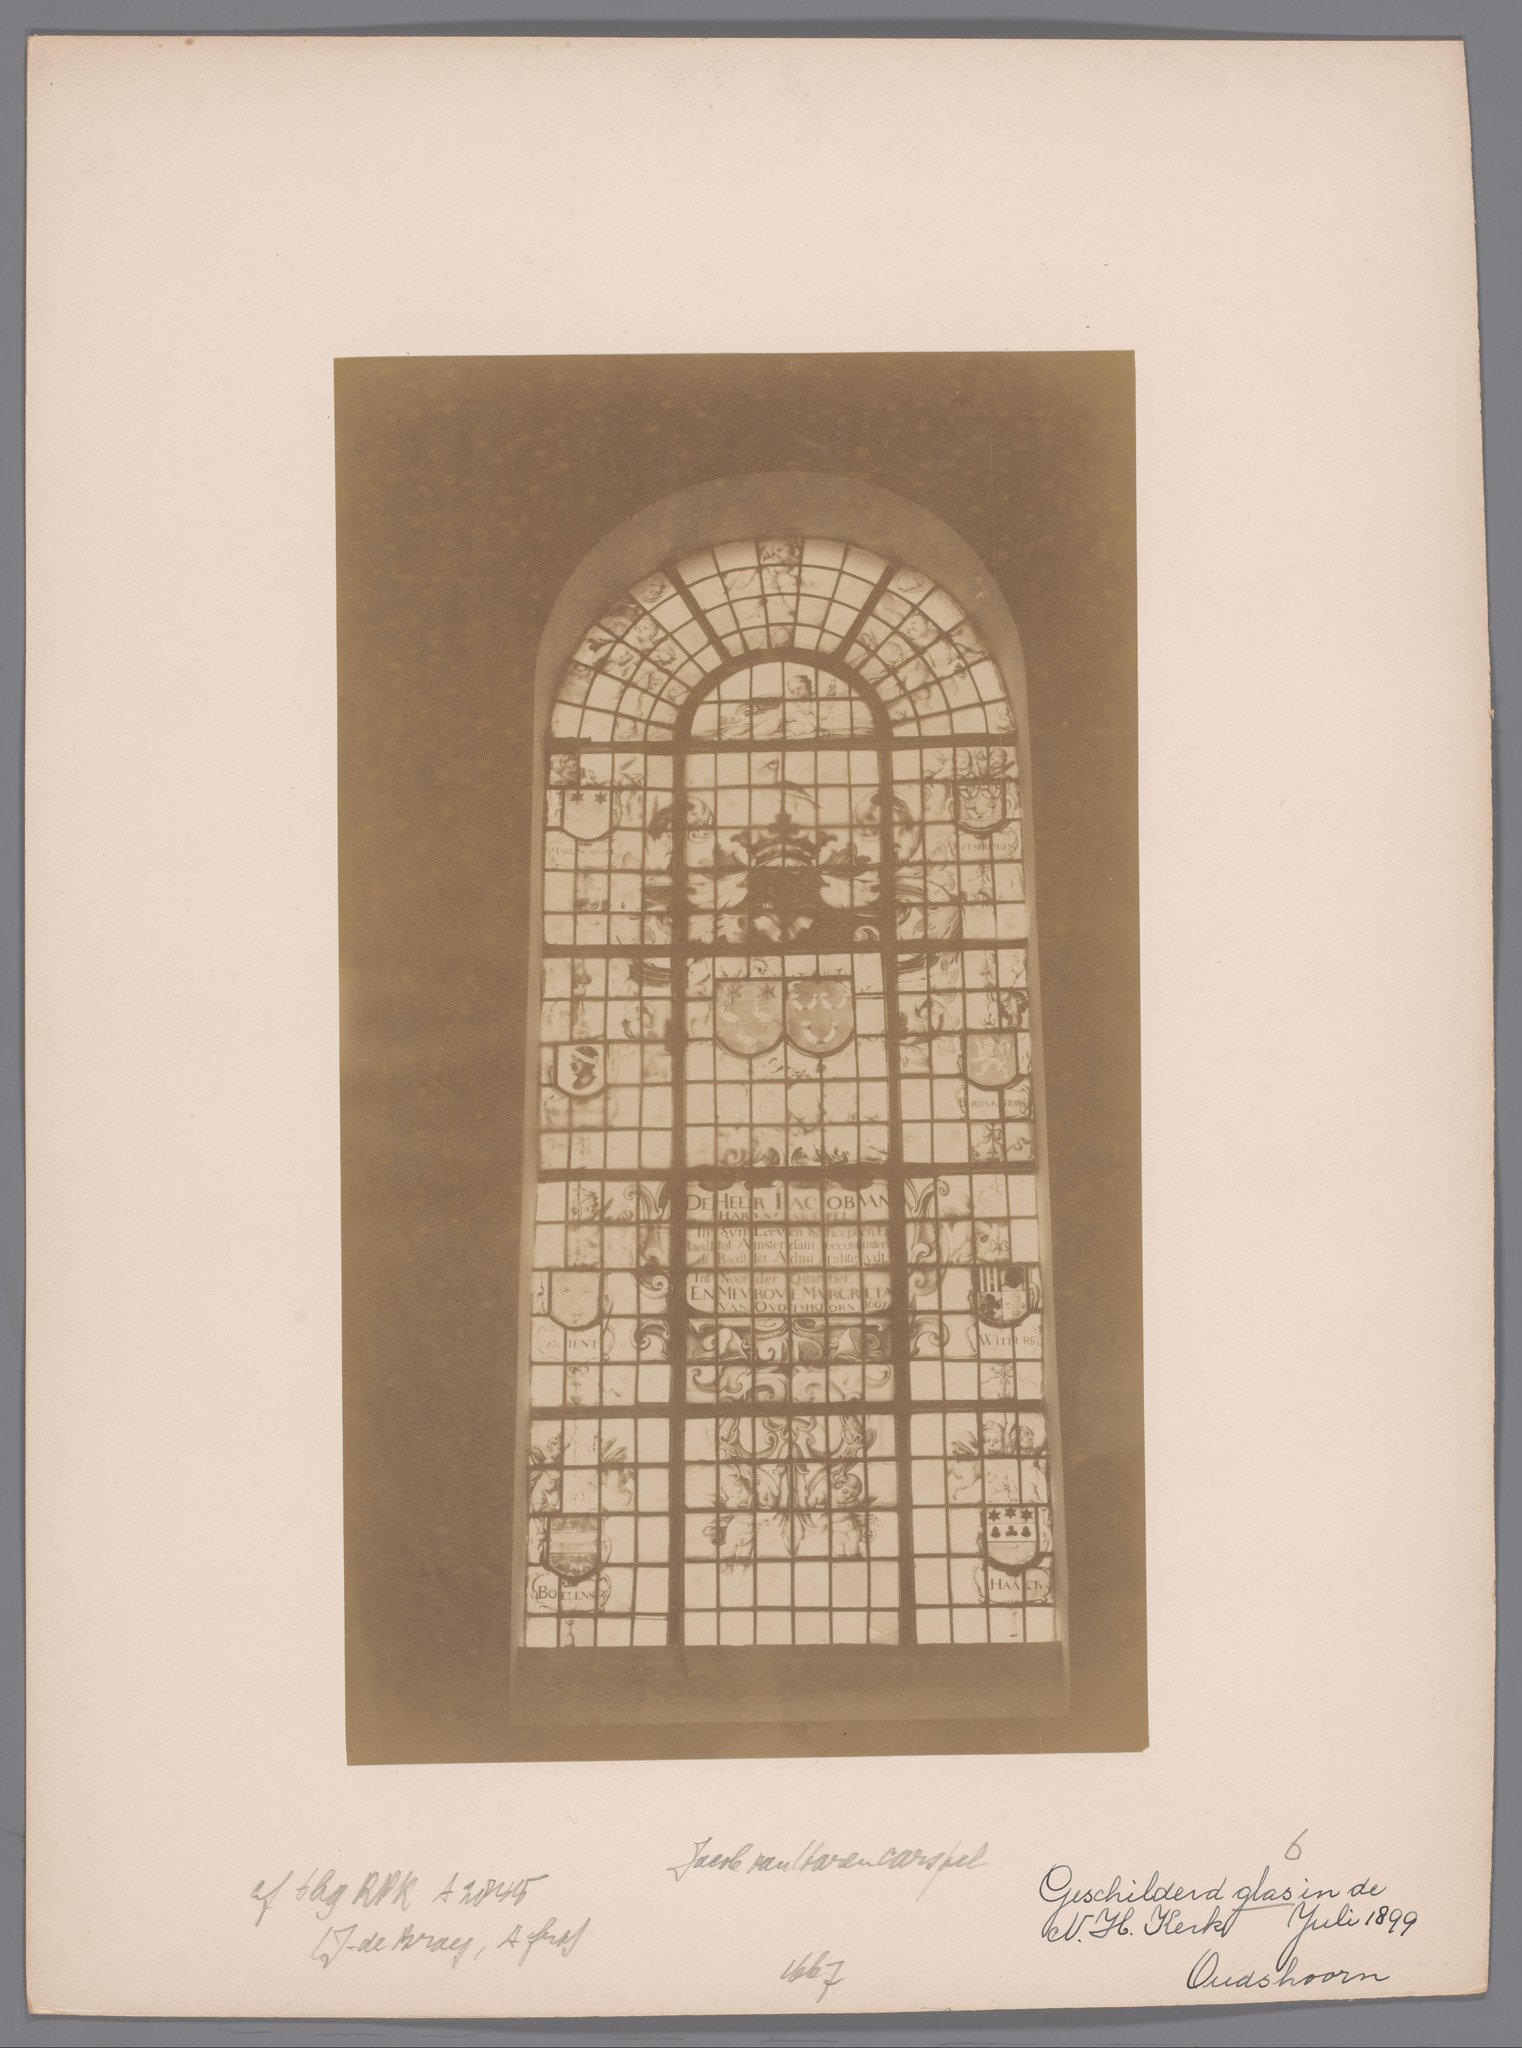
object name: photograph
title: Geschilderd raam in de Oudshoornse Kerk te Oudshoorn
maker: anoniem (monumentenzorg)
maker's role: fotograaf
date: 1899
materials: cardboard, photographic support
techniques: albumen print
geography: oudshoorn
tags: church-window, e.g. rose-window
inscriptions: annotation: ‘Geschilderd glas in de Ned Herv kerk te Oudshoorn/ Juli 1899’, annotation: ‘Geschilderd glas 6 in de N.H. Kerk Juli 1899/ Oudshoorn’, annotation: ‘[...] RPK A2843 [...]/ Jacob van Harencarspel 1667’